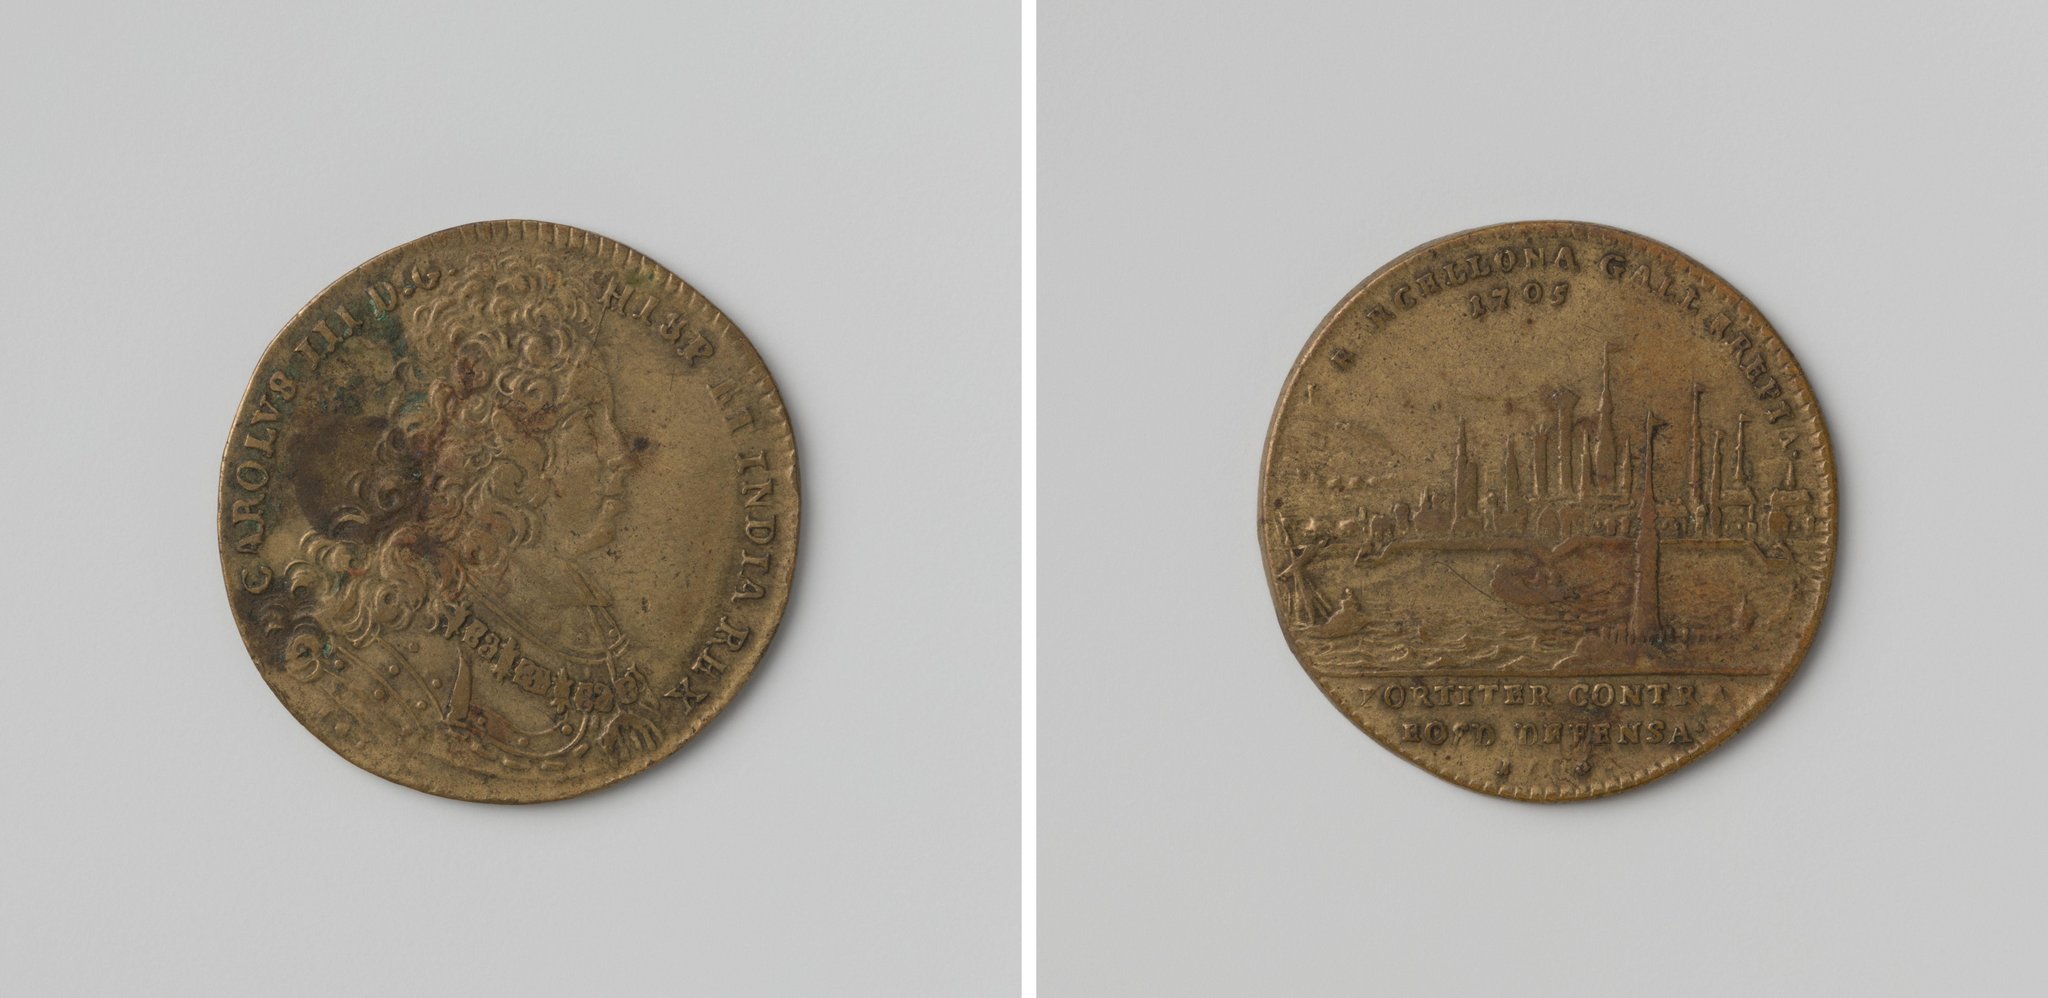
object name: jeton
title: Inname en ontzet van Barcelona, rekenpenning geslagen ter ere van Karel III, koning van Spanje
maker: Anonymous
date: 1706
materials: brass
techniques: striking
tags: vienna, charles vi (holy roman emperor)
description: Messing penning. Voorzijde: borststuk man binnen omschrift. Keerzijde: gezicht op stad Barcelona aan haven binnen omschrift; afsnede: opschrift